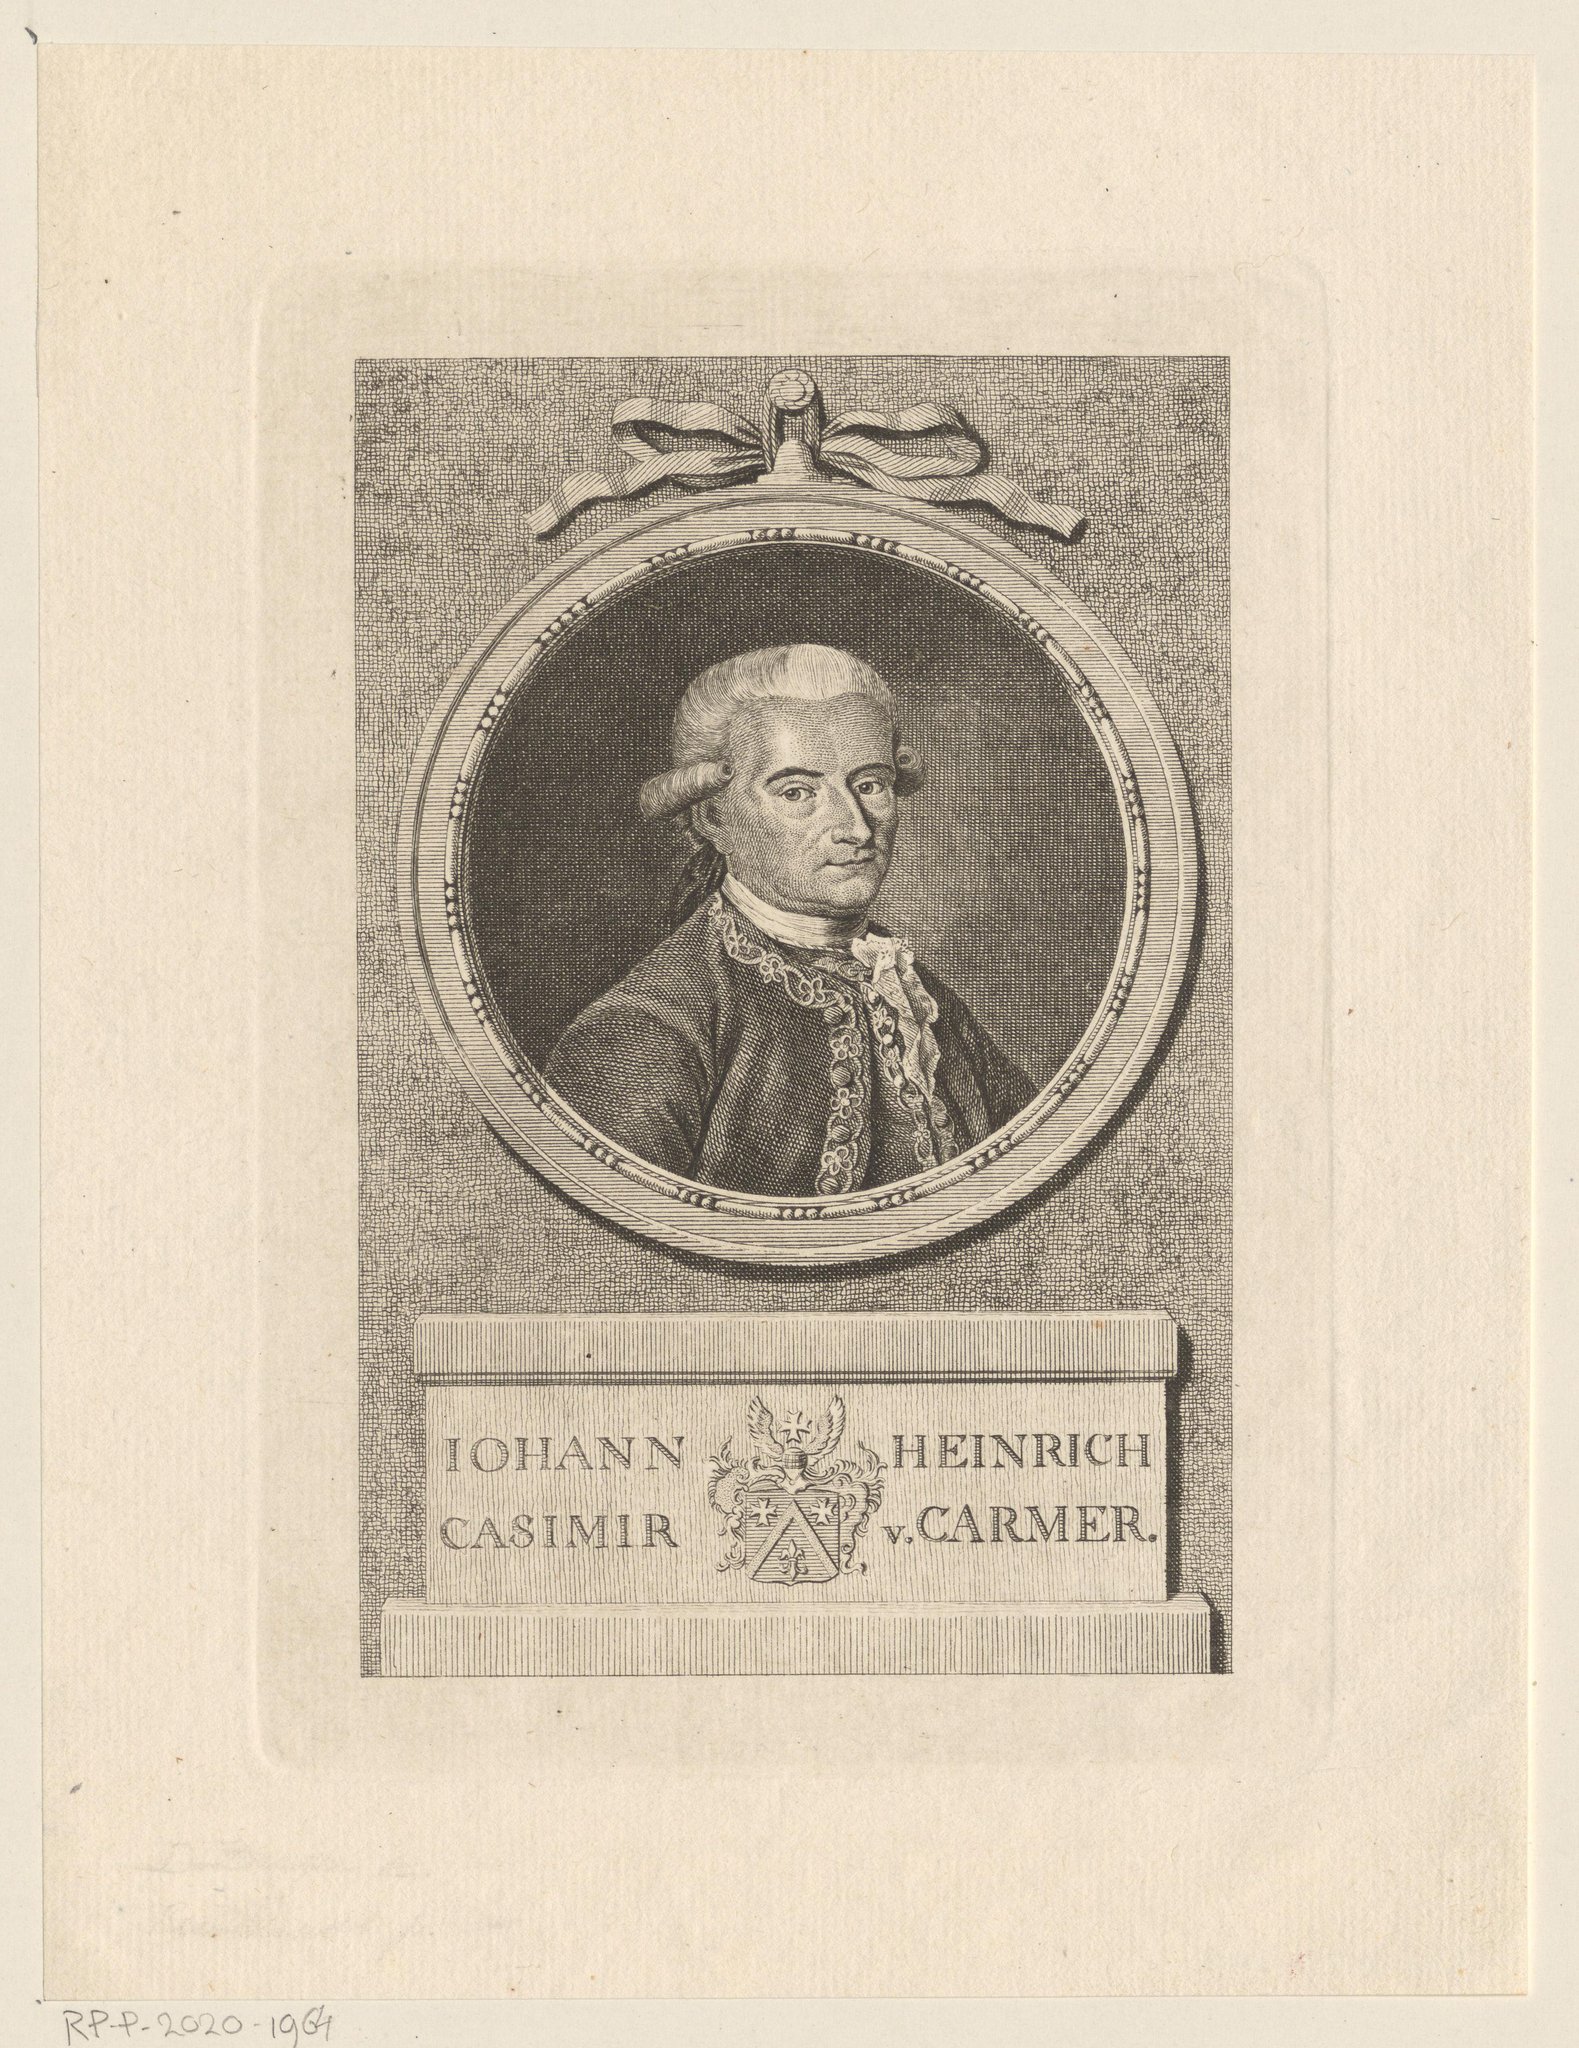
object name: print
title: Portret van Johann Heinrich Casimir Carmer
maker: daniel berger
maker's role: print maker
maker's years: 1744-1824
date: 1776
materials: paper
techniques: engraving, etching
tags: historical persons, armorial bearing, heraldry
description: Prent waarschijnlijk uit: Krünitz, Johann Georg. Oeconomische Encyclopädie, oder allgemeines System der Land- Haus- und Staats-Wirthschaft. 72 dln. Berlijn: Joachim Pauli, 1776, dl. 8.